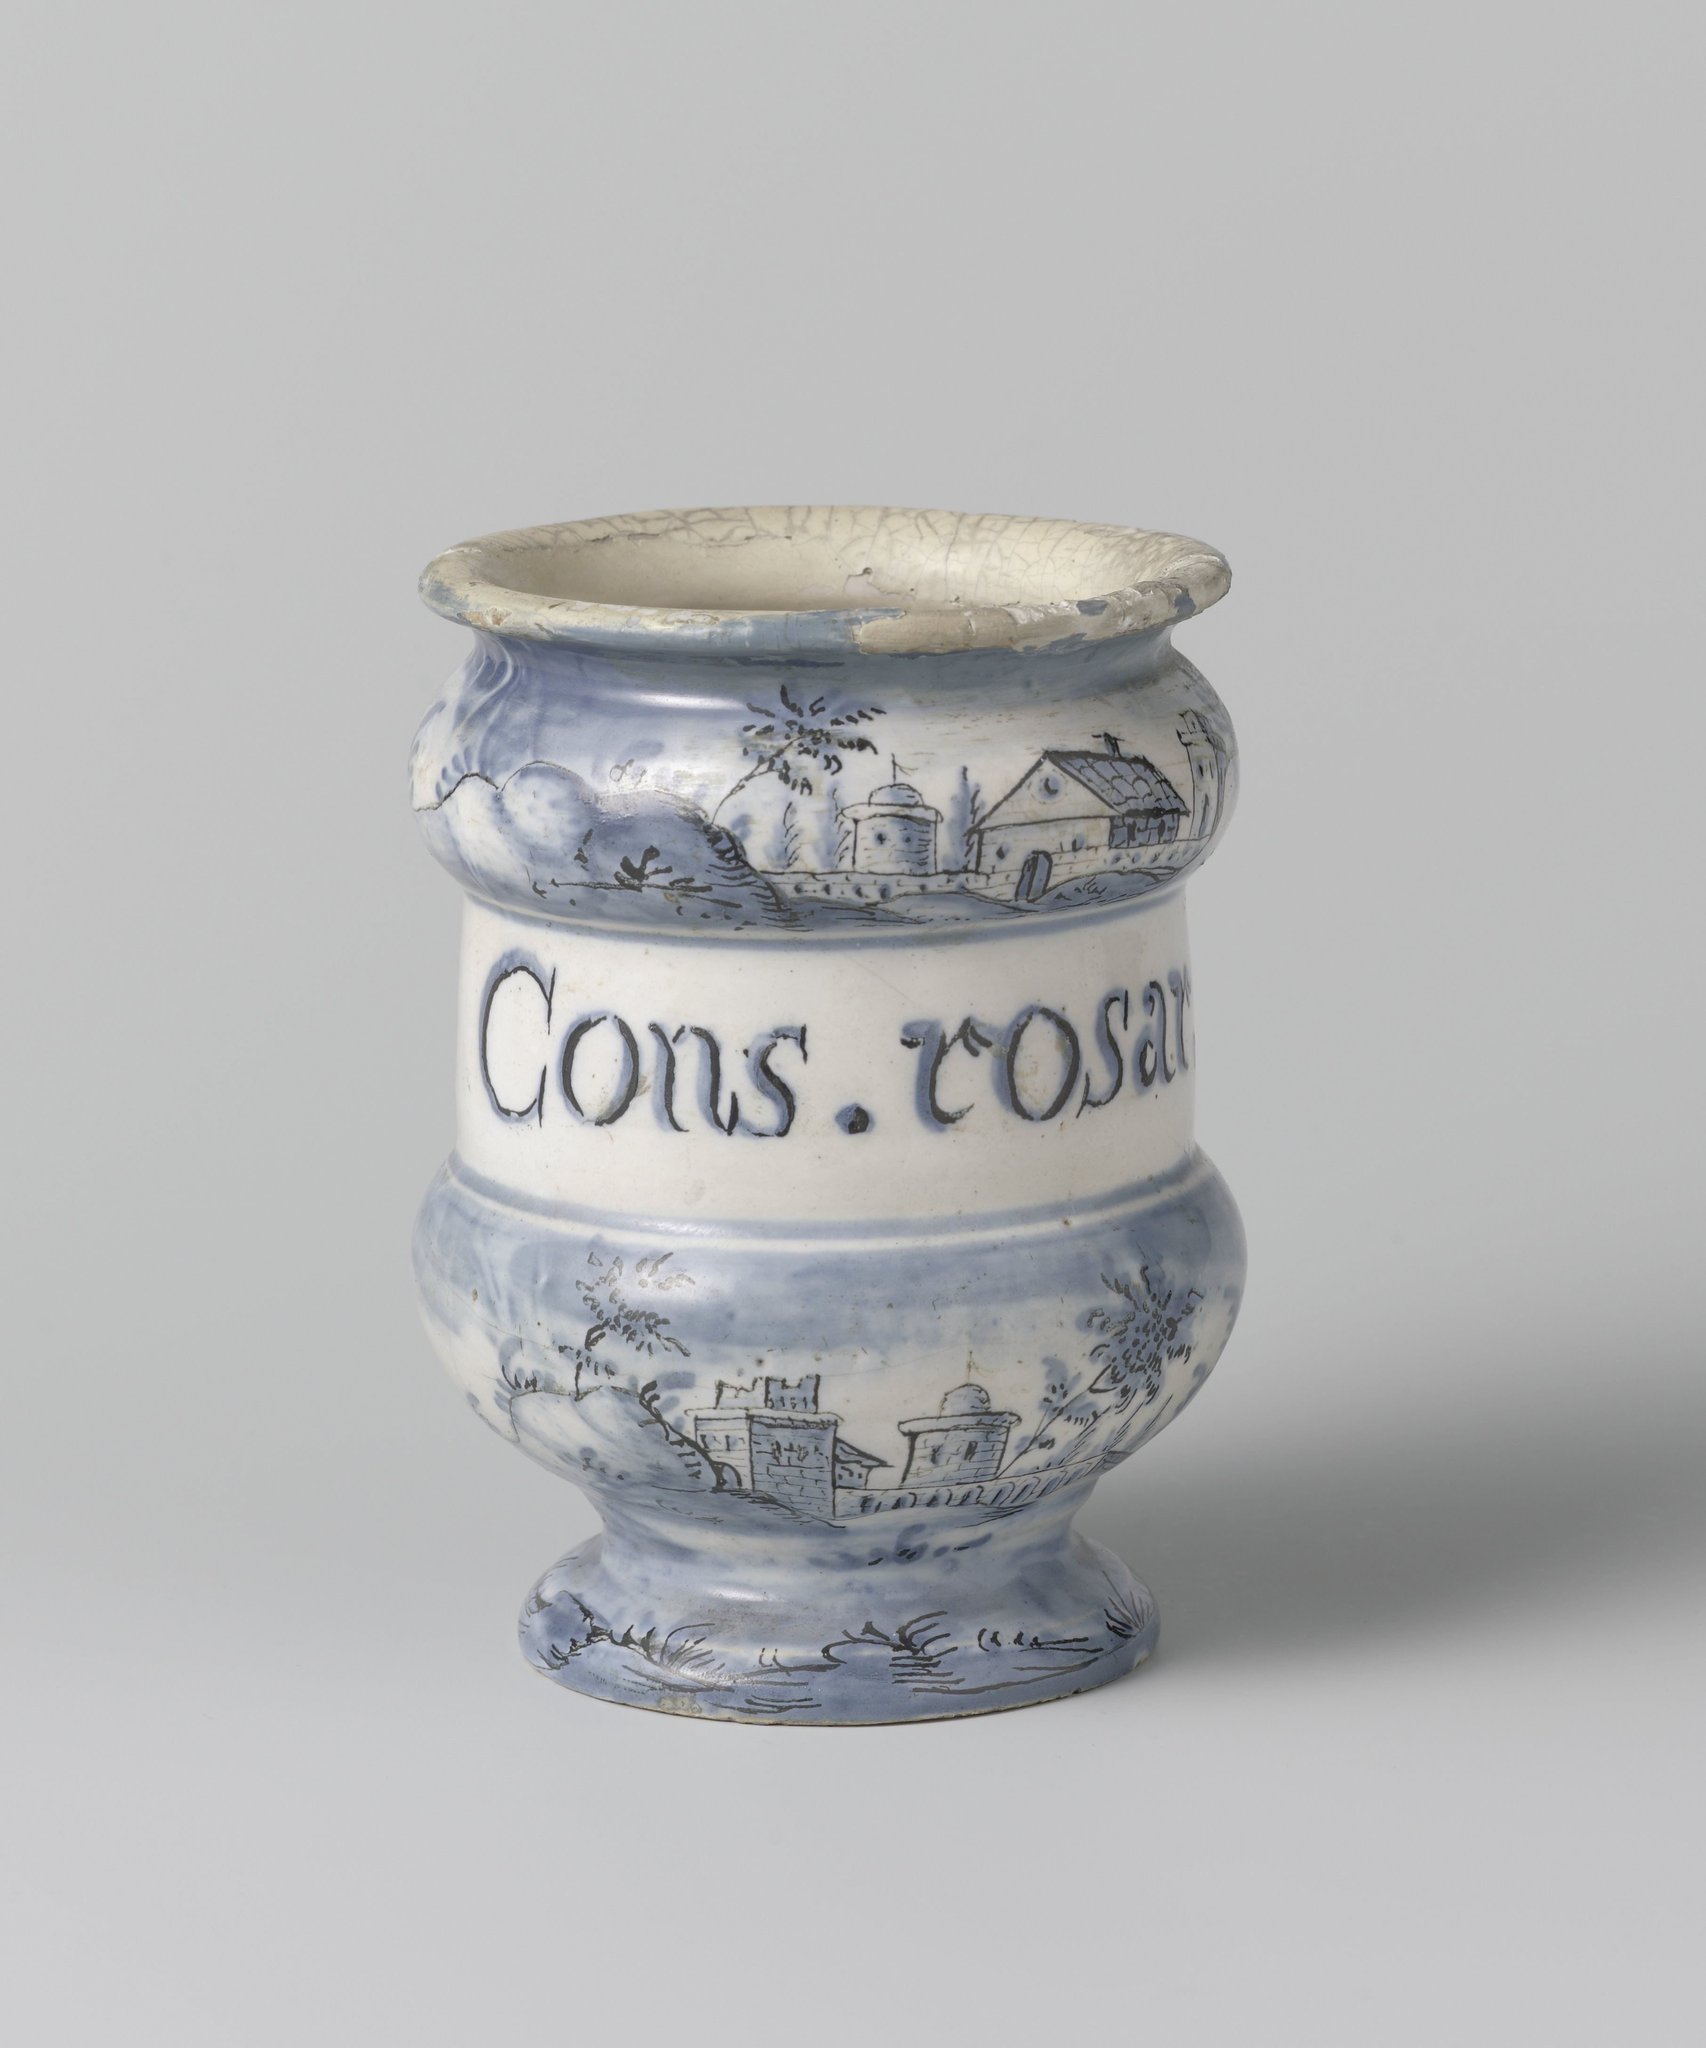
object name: apothecary jar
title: Apothekerspot met tekst: Cons. rosar. rub.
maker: Anonymous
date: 1400-1950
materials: earthenware, paint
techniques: vitrification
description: Apothekerspot met in blauw een landschap en de tekst: Cons. rosar. rub.